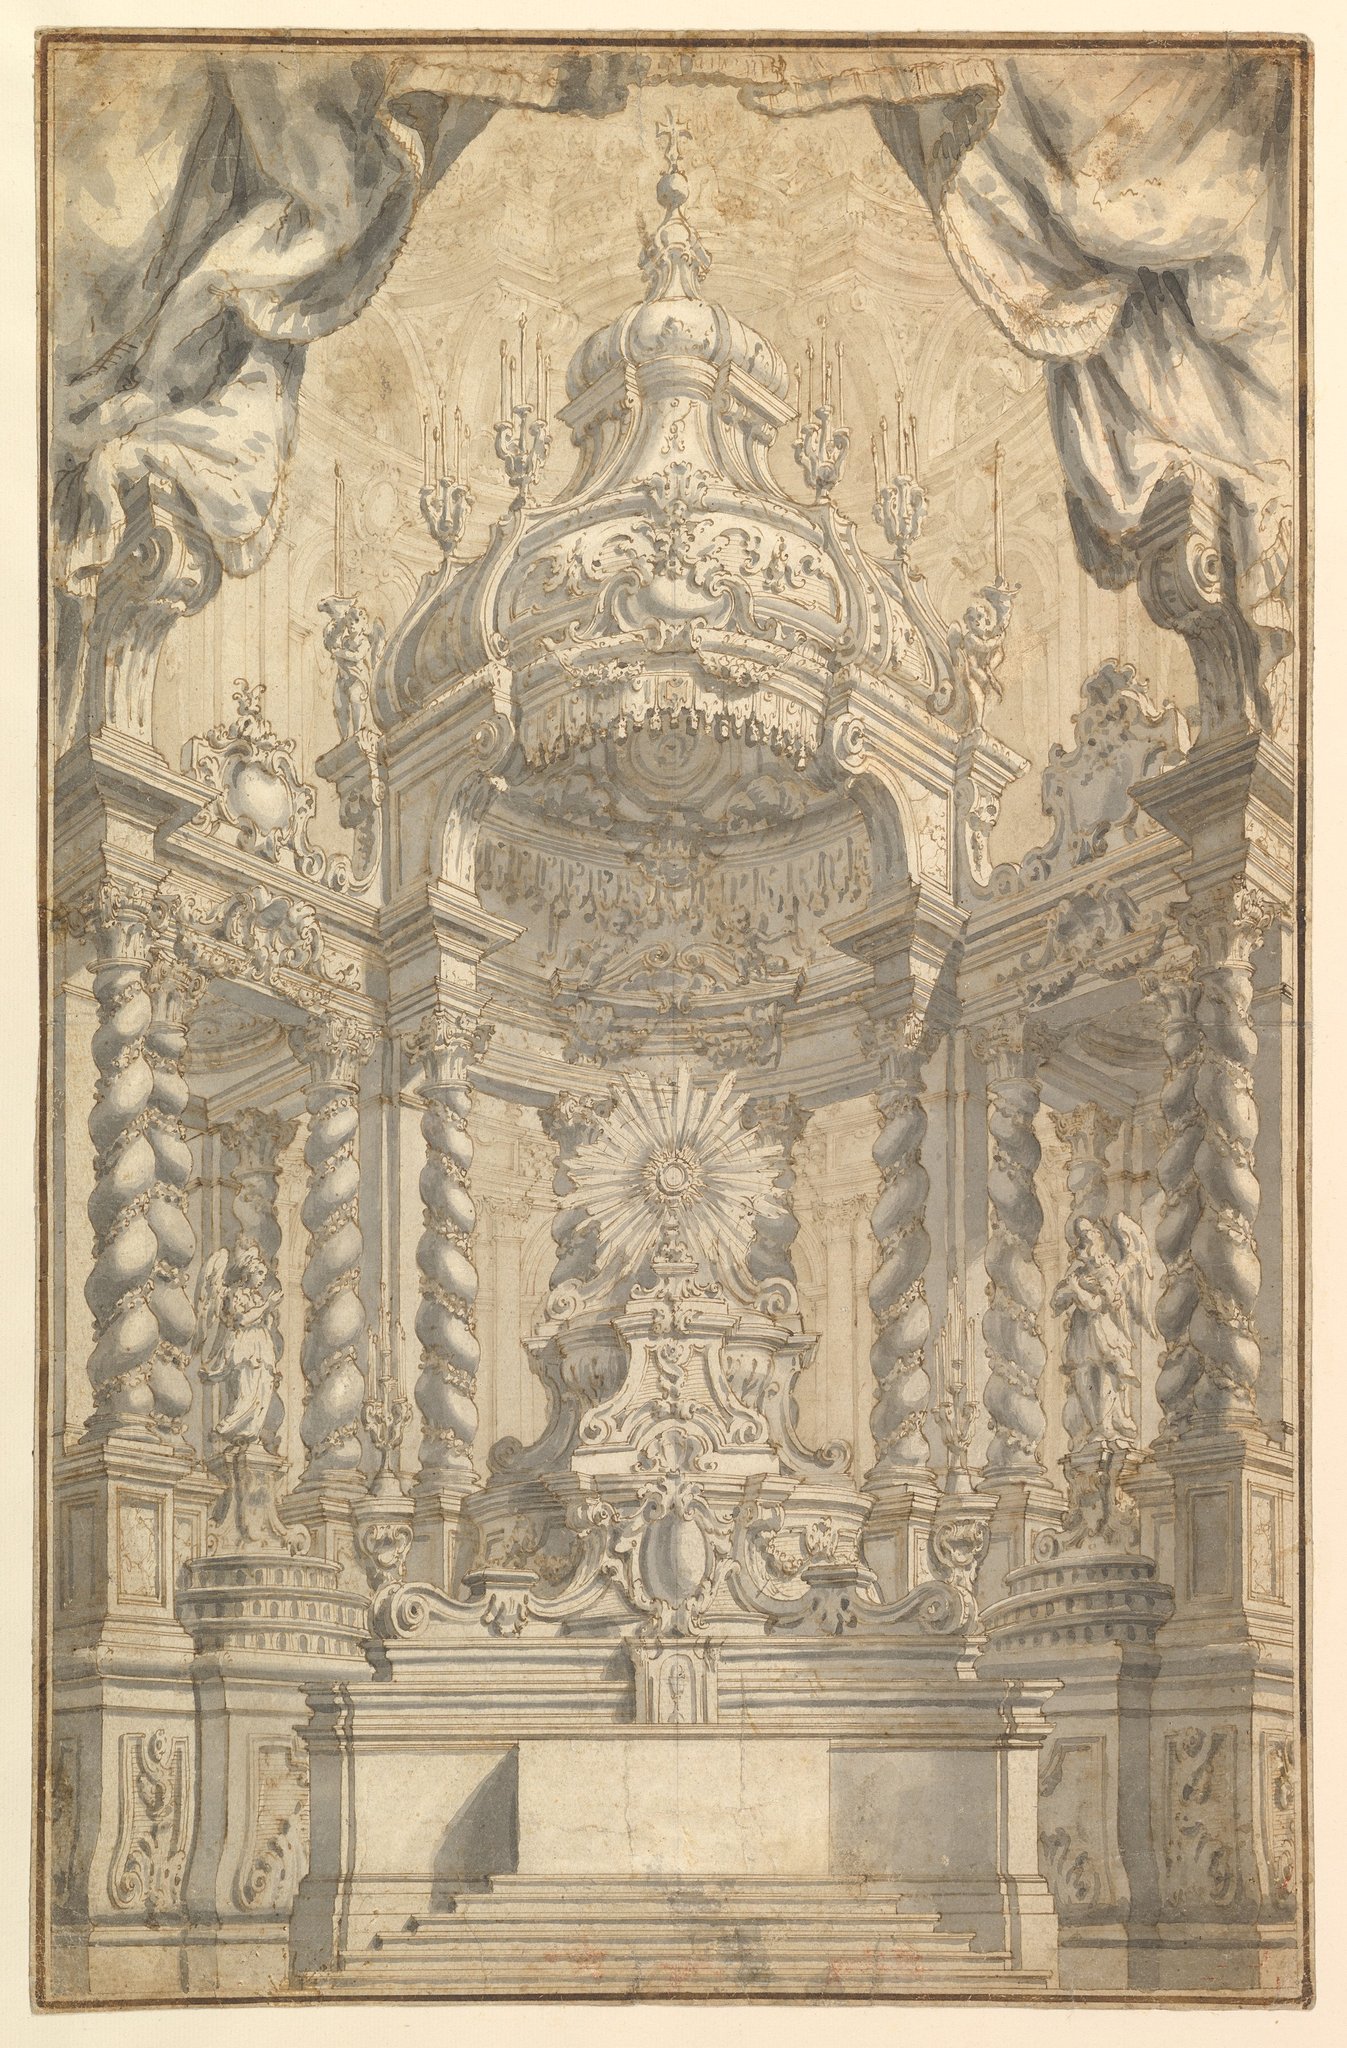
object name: drawing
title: Design for Altar Decorations for a Liturgical Celebration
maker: anonymous, italian, piedmontese, 18th century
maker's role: artist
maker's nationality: italian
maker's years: 1700-1800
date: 1750-1775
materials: ink, paper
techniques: brush, pen, wash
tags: altars